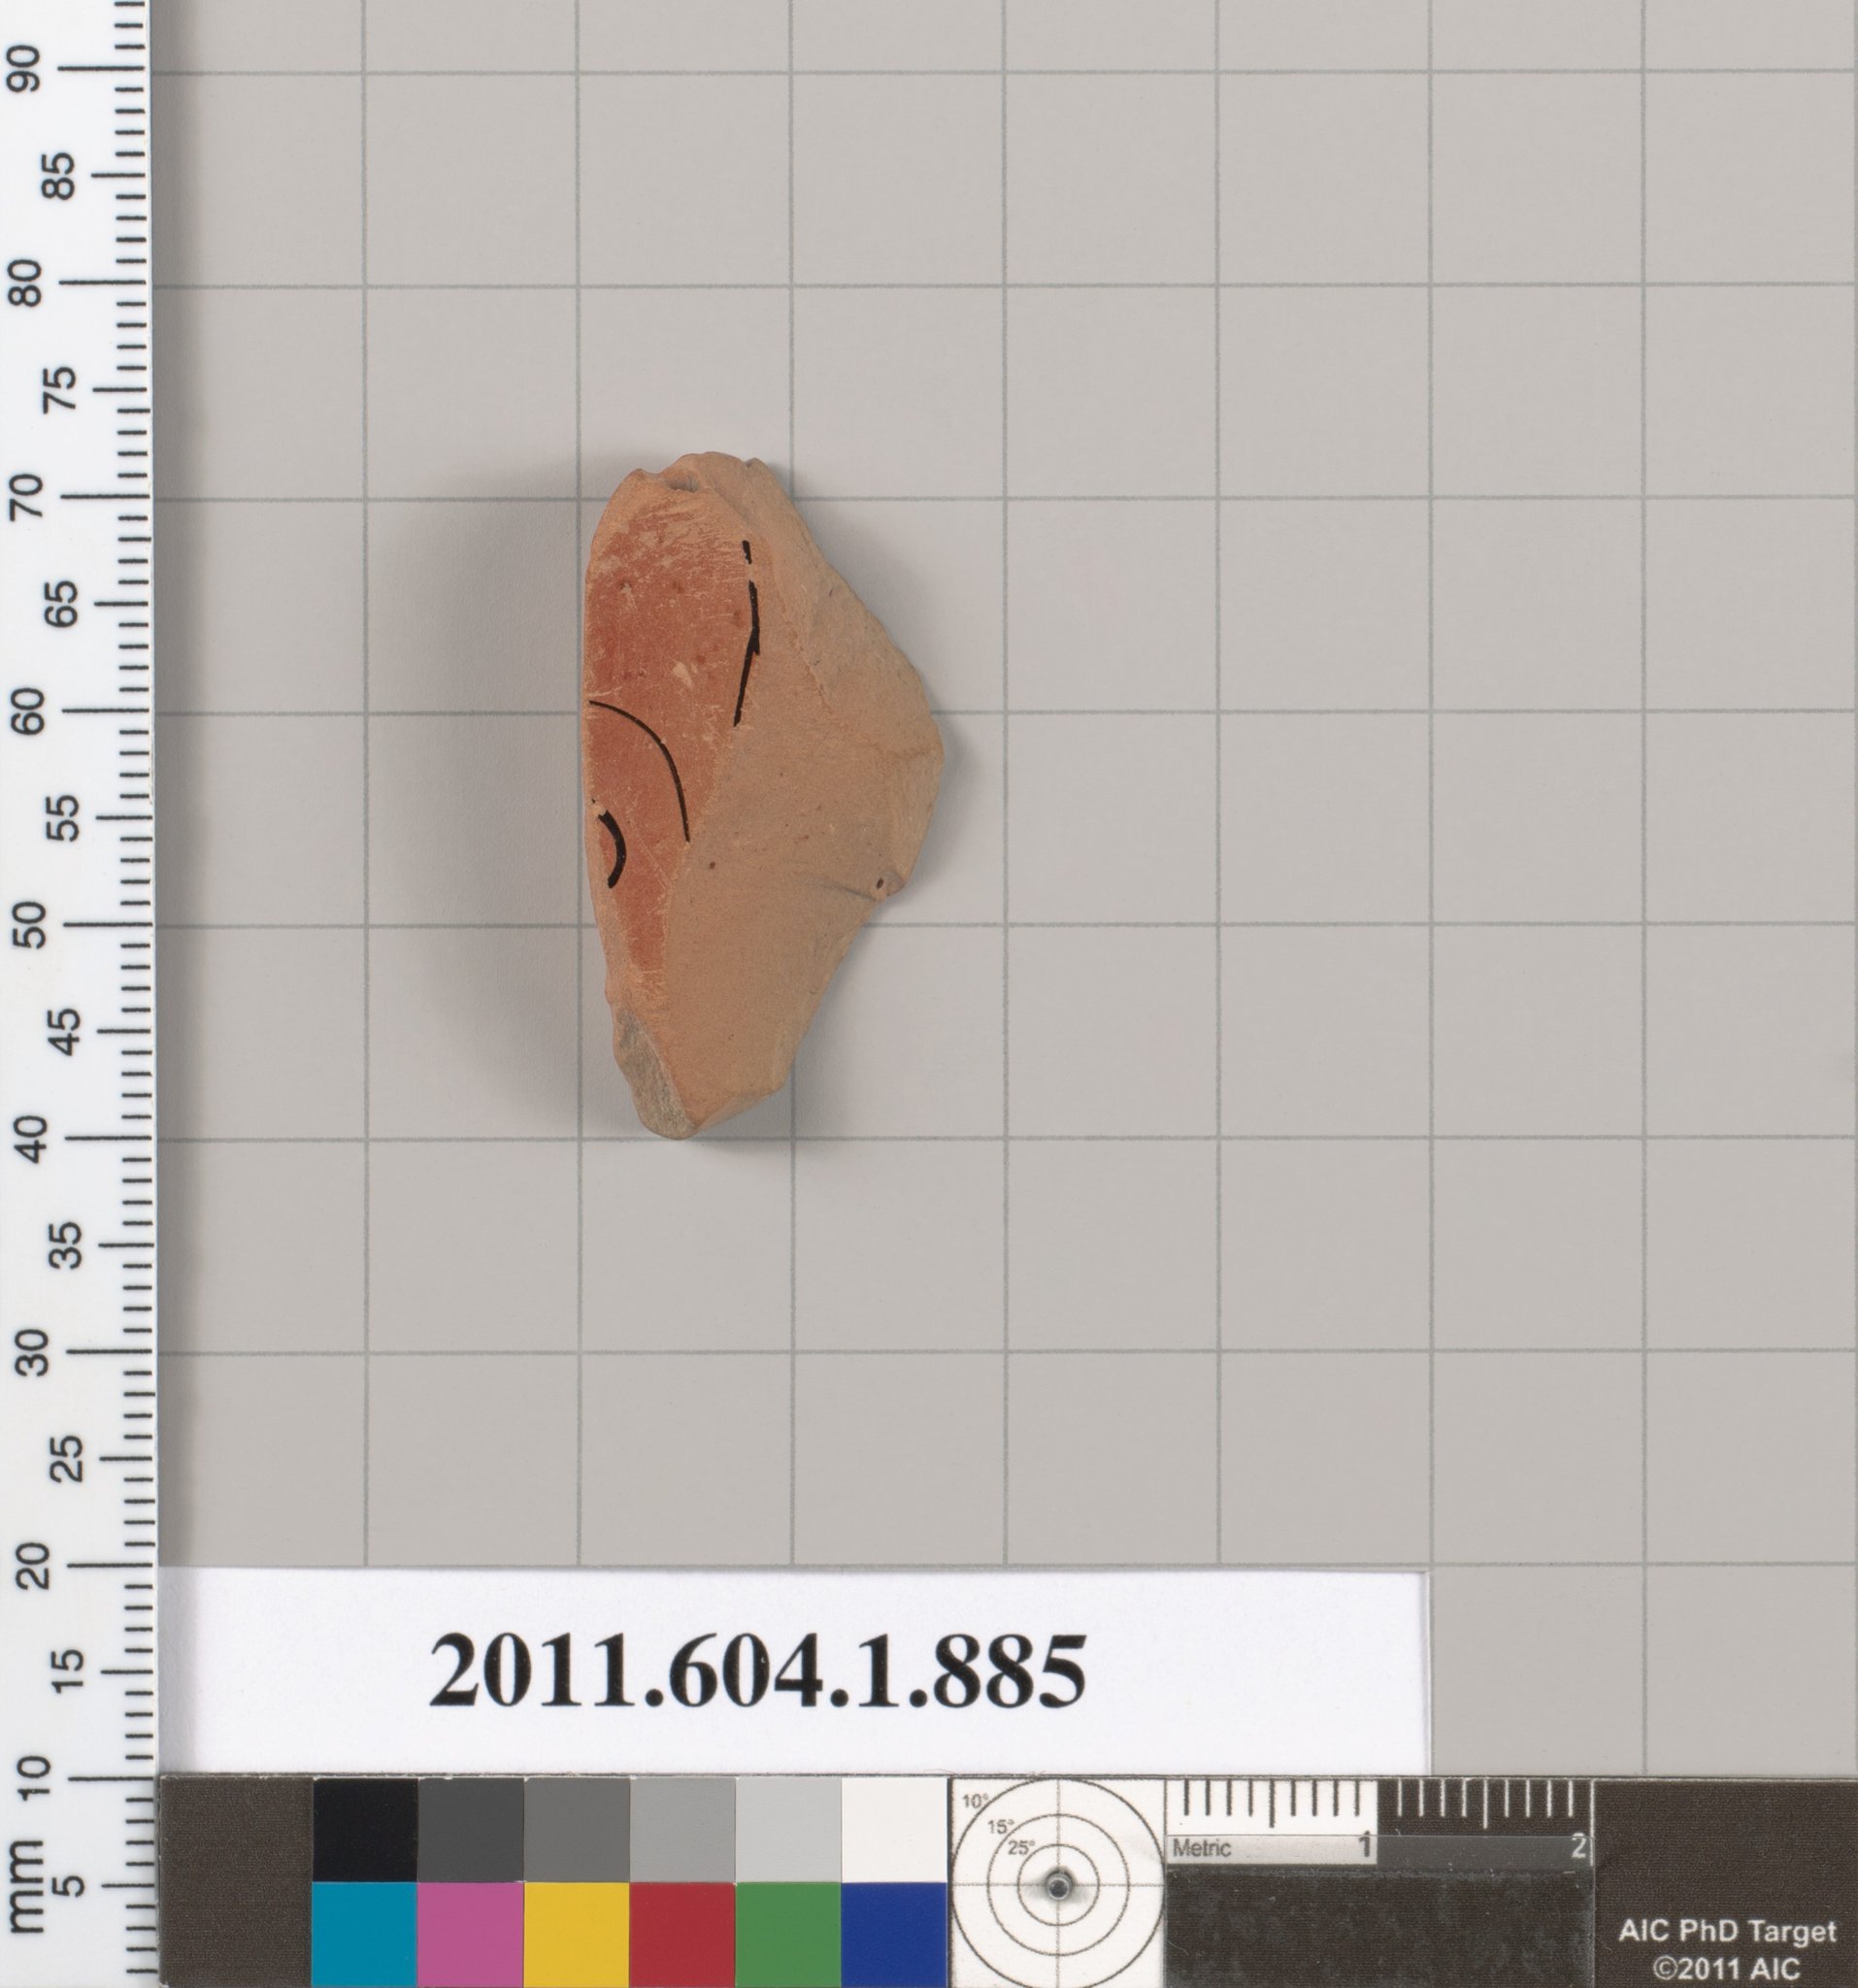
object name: kylix fragment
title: Terracotta fragment of a kylix (drinking cup)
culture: greek, attic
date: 475-451 BCE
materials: terracotta